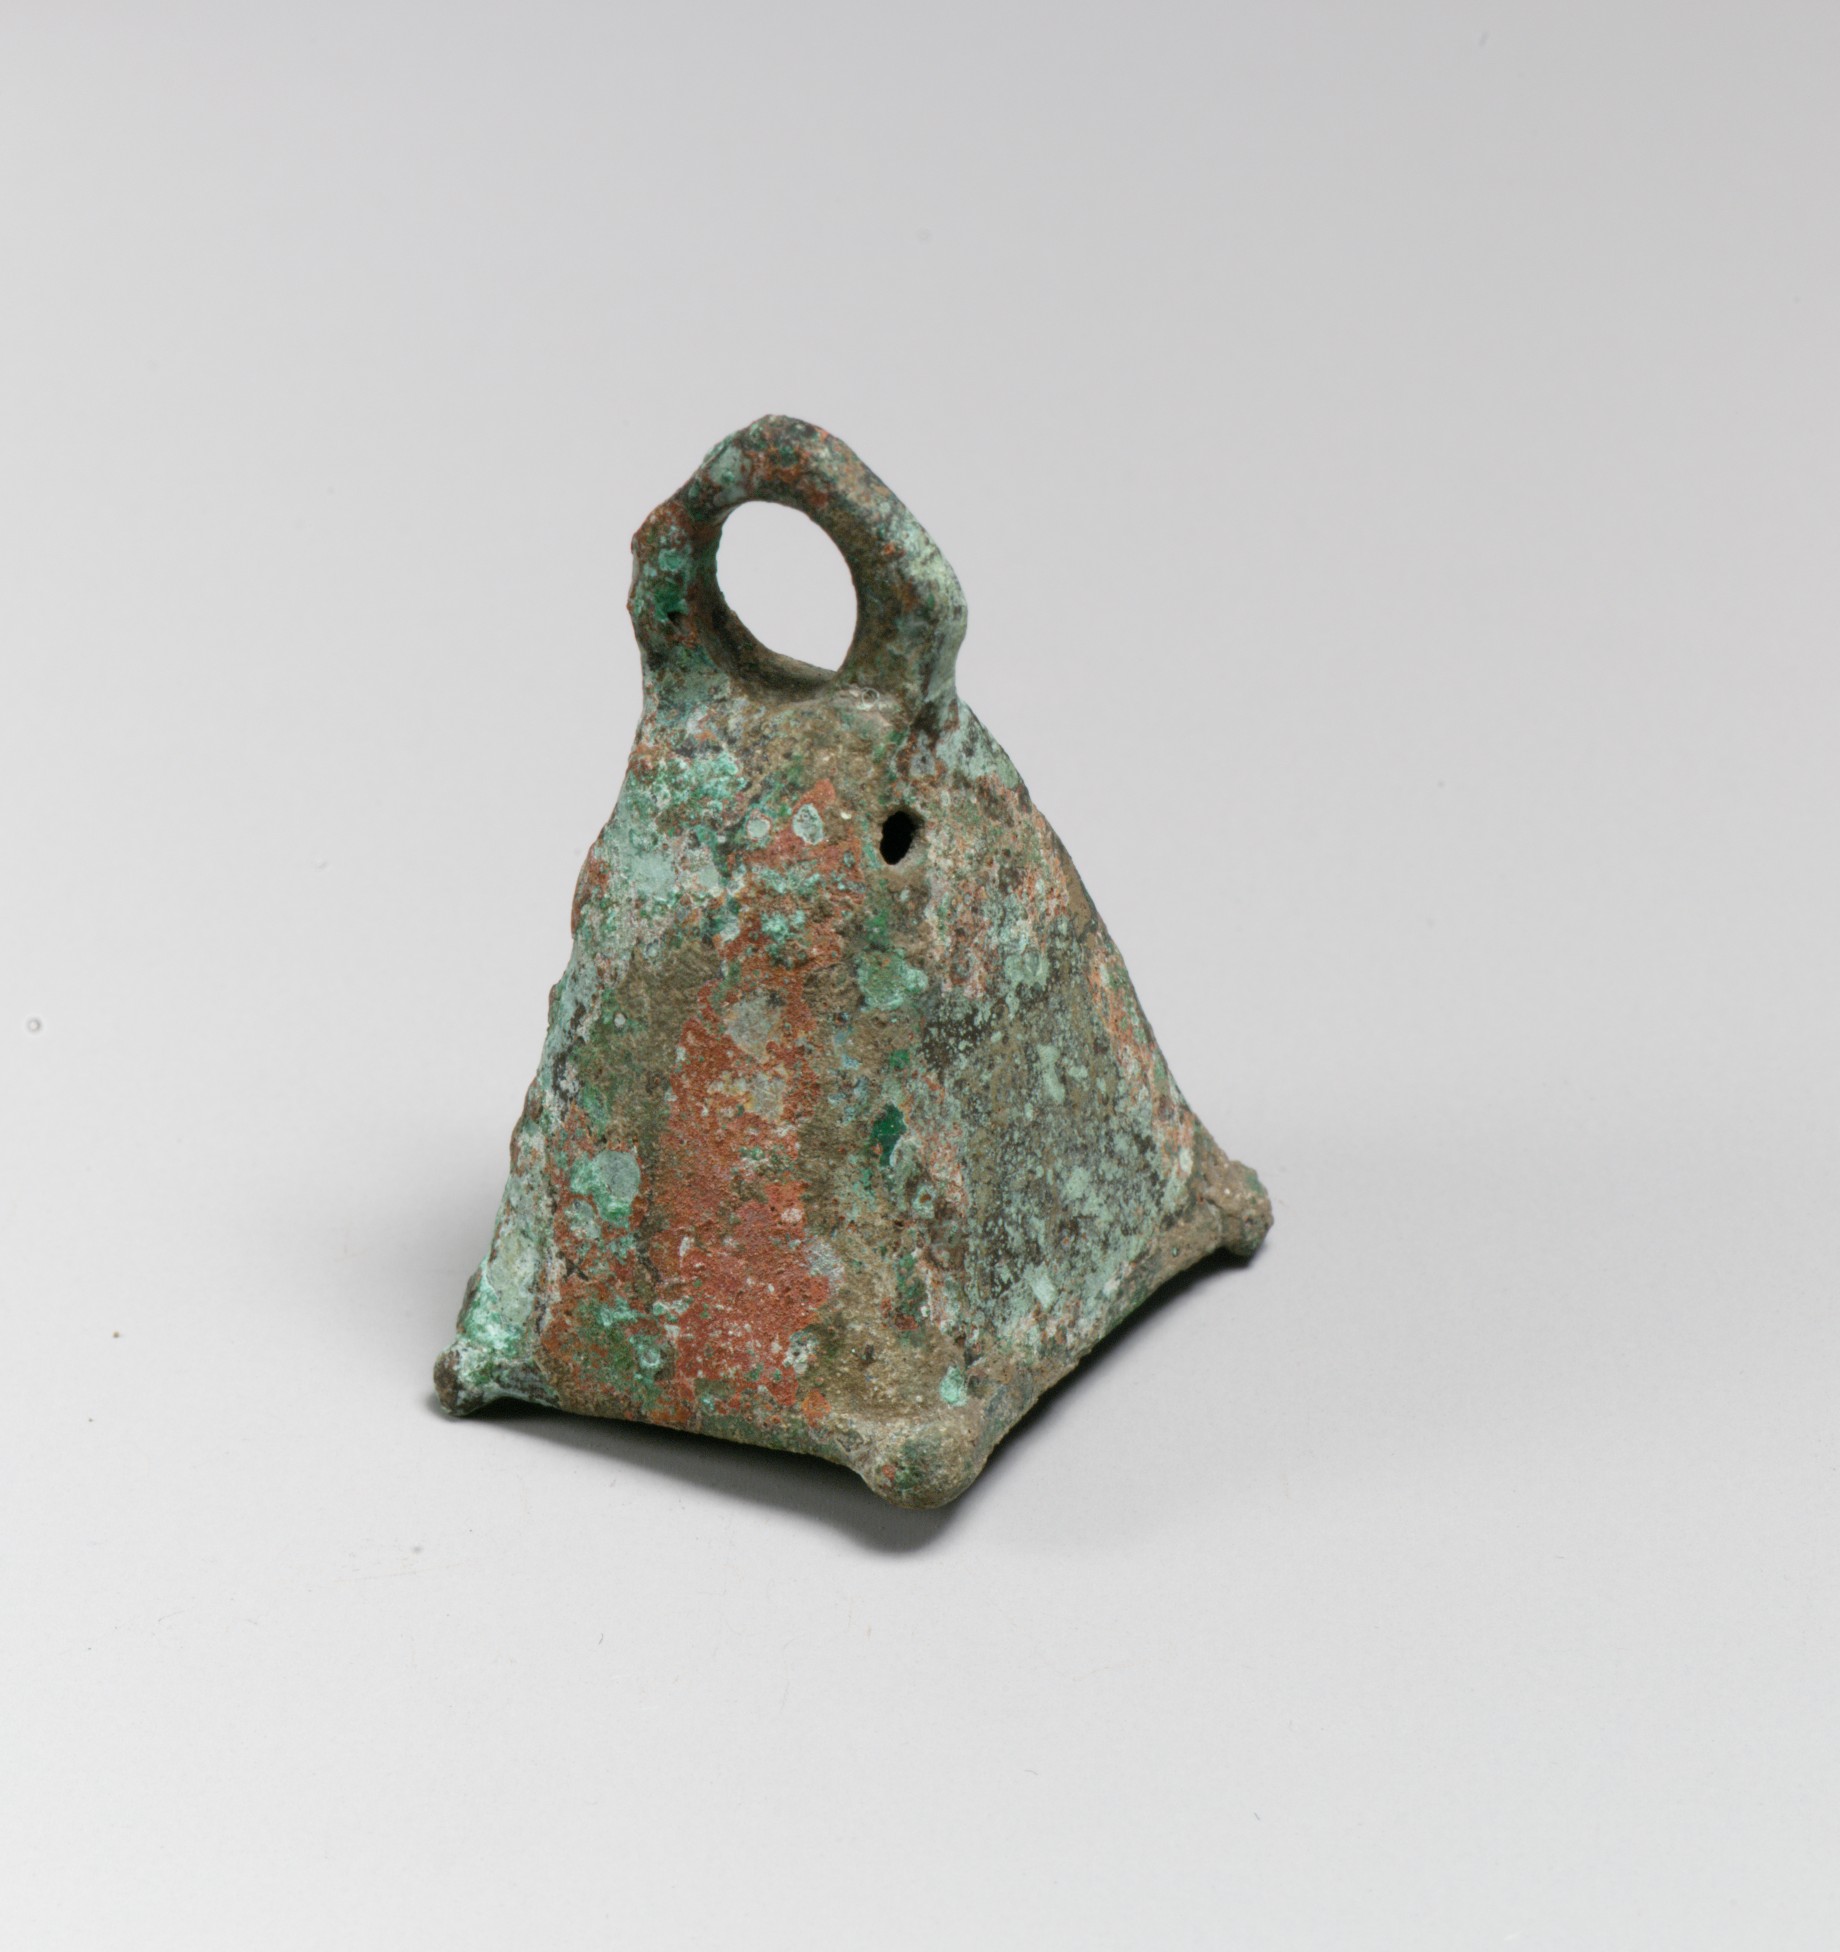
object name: bell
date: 7000 BCE-330 CE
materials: bronze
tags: musical instruments